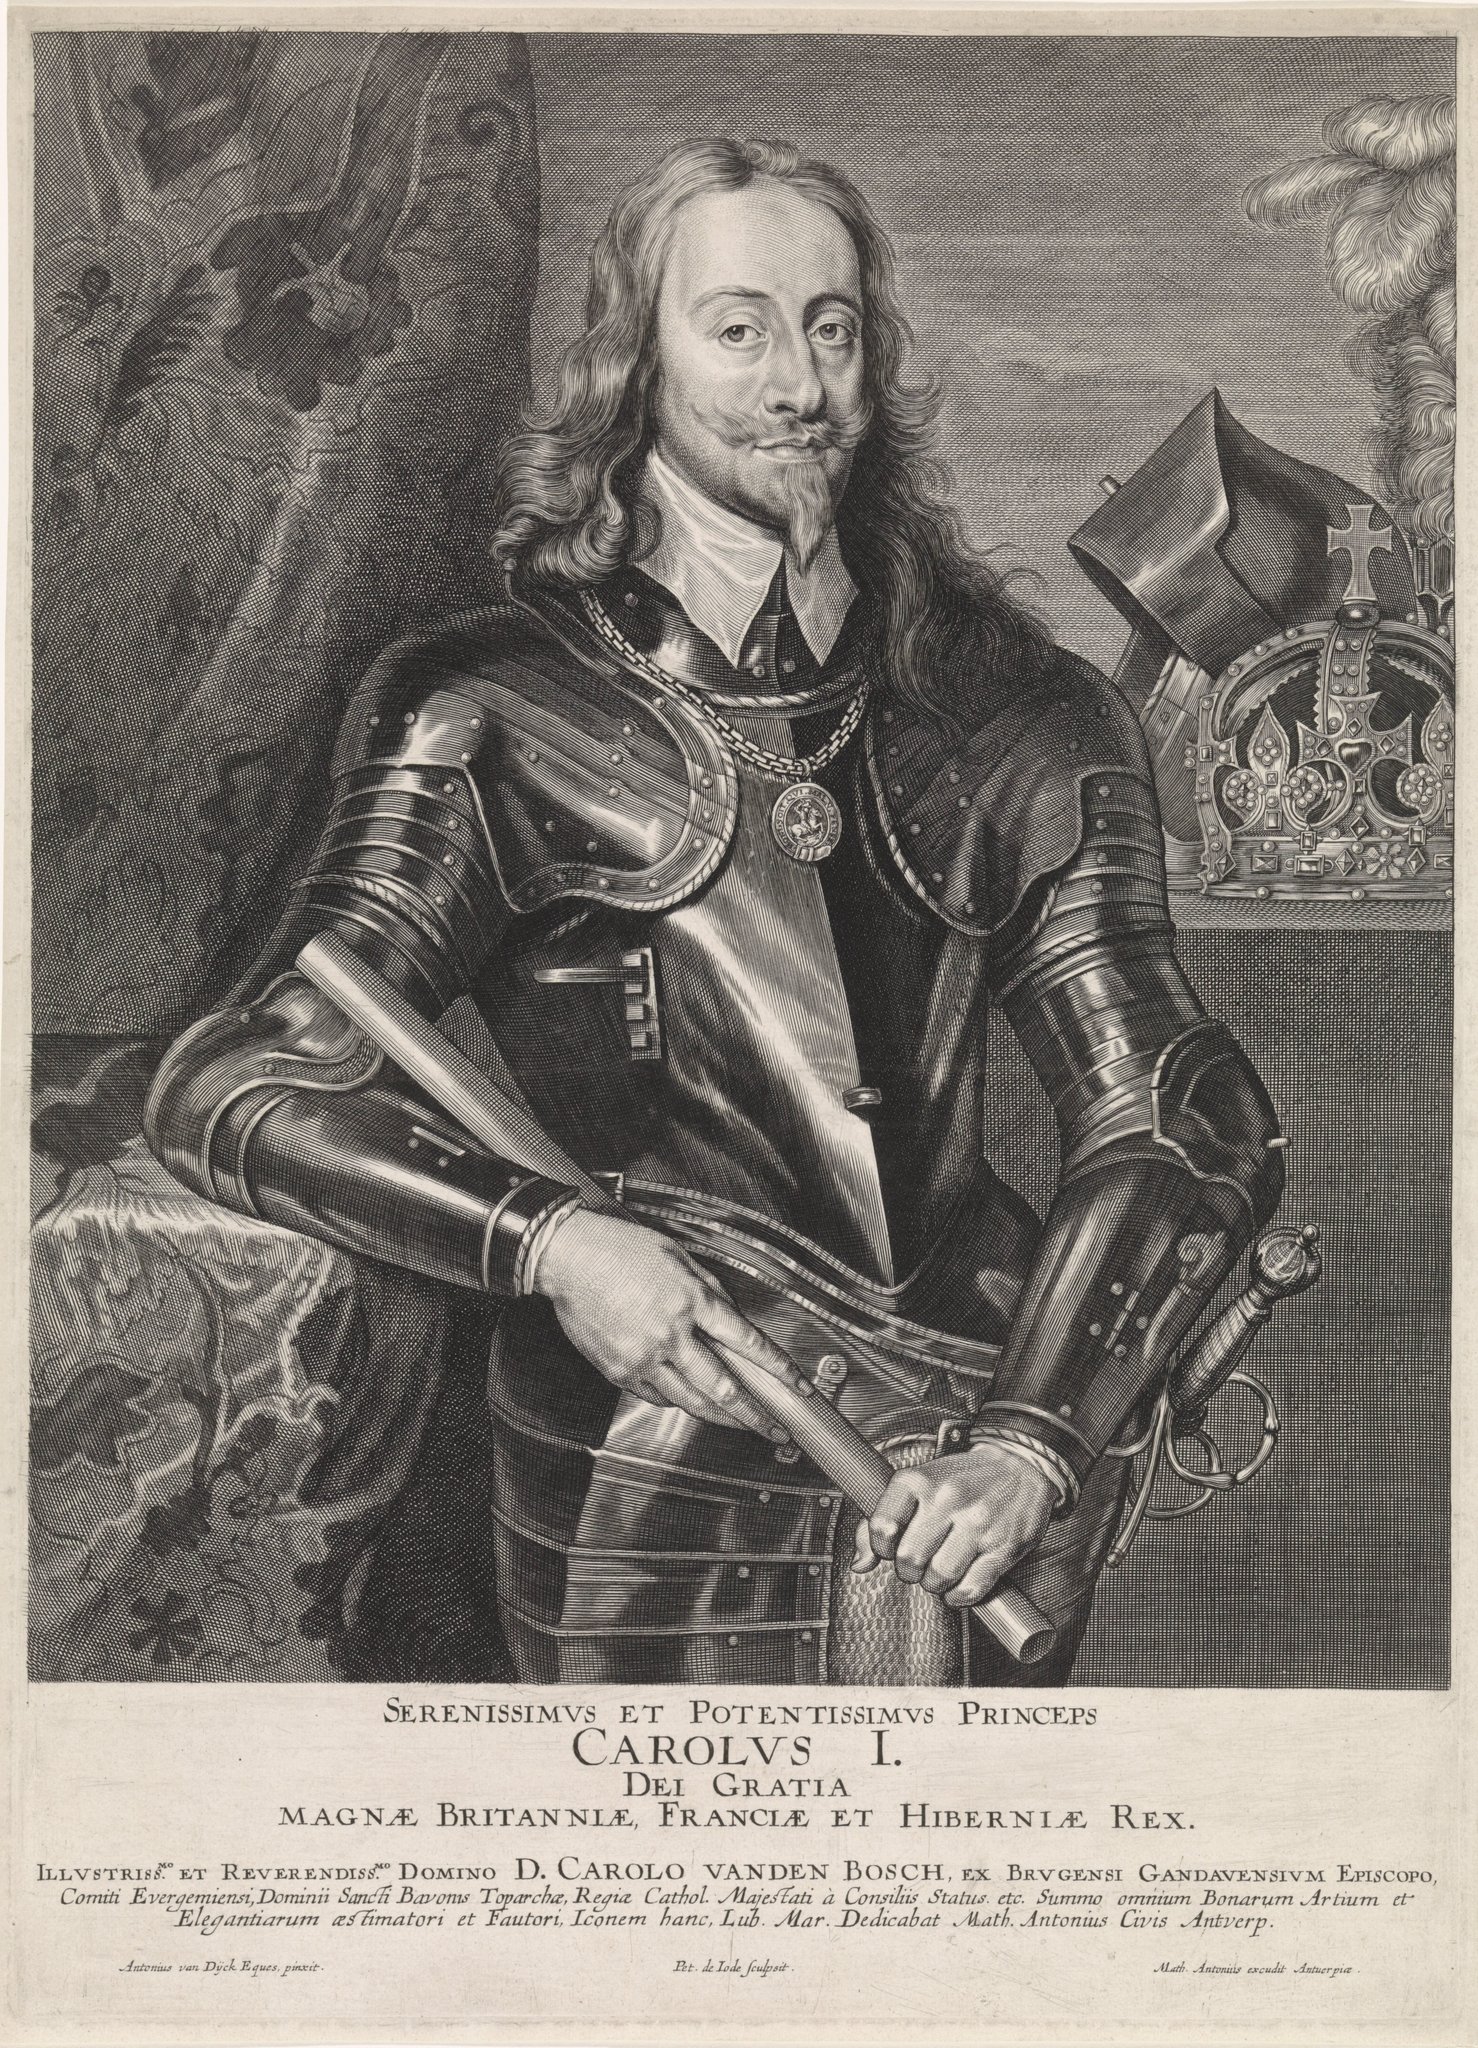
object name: print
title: Portret van Karel I, koning van Engeland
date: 1628-1670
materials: paper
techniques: engraving, etching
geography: antwerp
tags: london, karel i (koning van engeland), crown (symbol of sovereignty)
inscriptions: collector's mark: Lugt 240, inscription: ‘Van Dyck N. 1(?)’, inscription: ‘6 - 0’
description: Portret van Karel I, koning van Engeland, ten halven lijve. Hij draagt een harnas en houdt met beide handen een commandostok vast. Achter hem een tafel met daarop zijn helm en zijn kroon. In de marge de naam van de geportretteerde en een onderschrift in het Latijn.